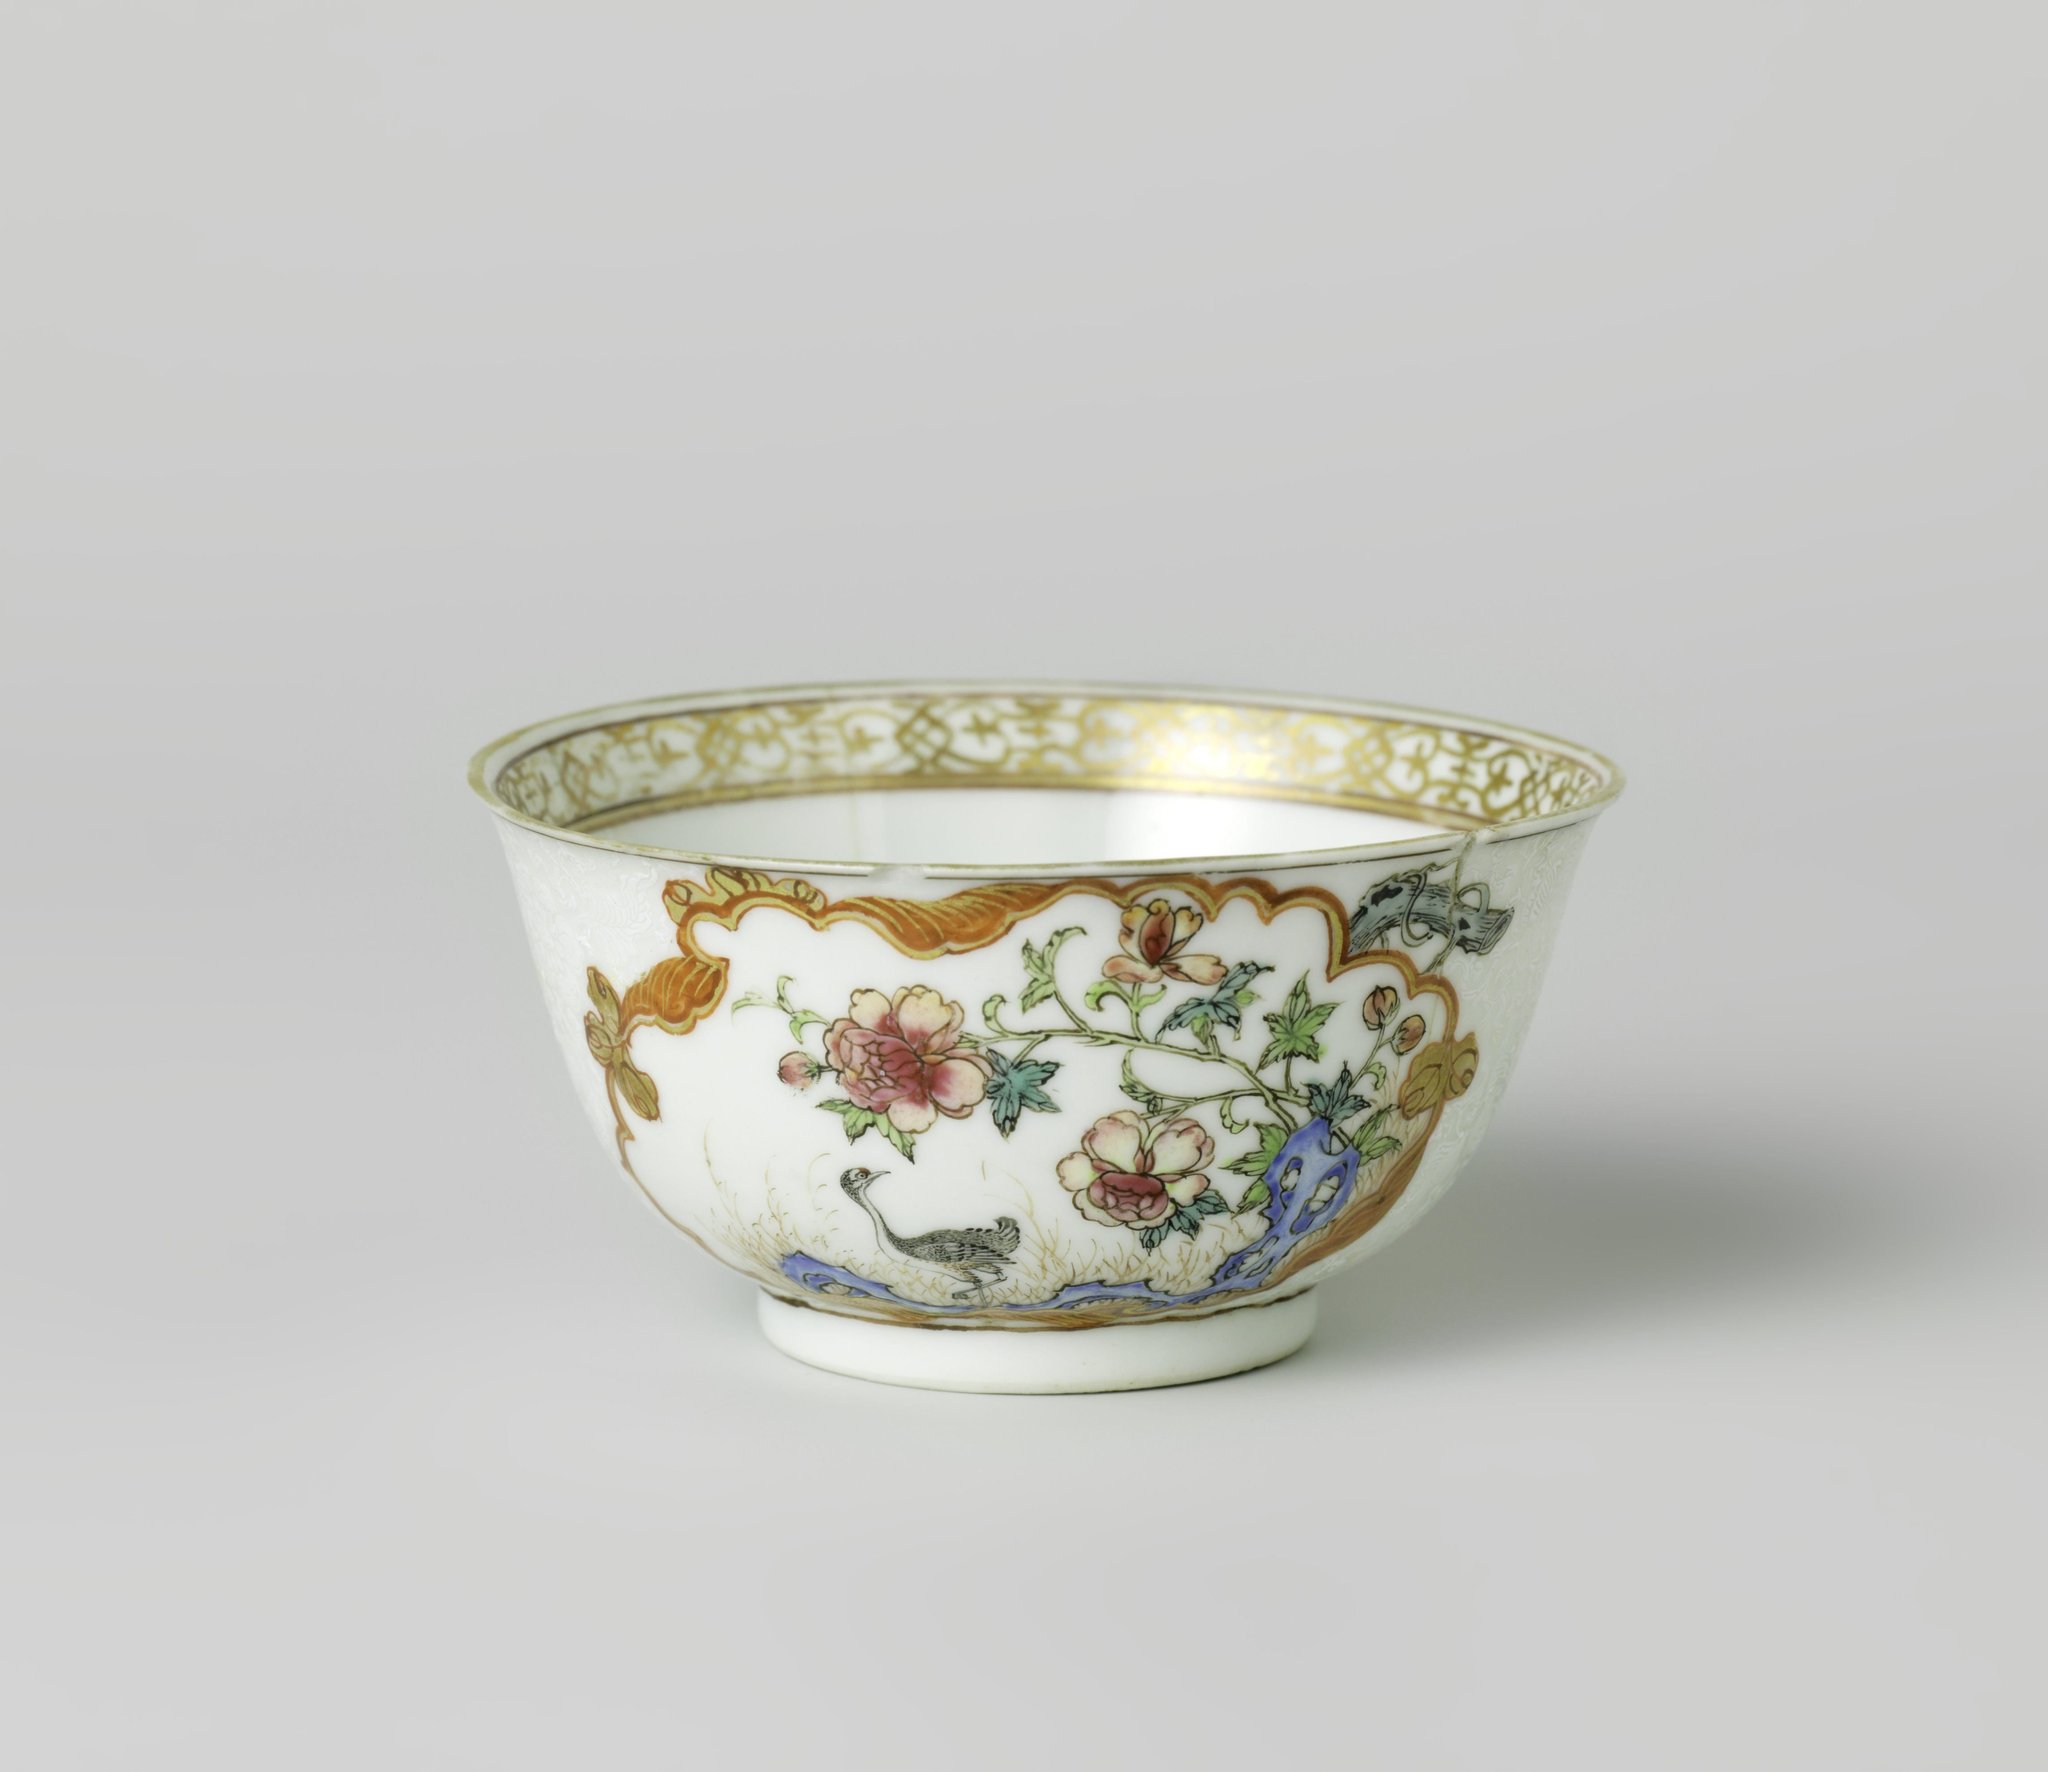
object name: cup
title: Bell-shaped cup with a crane near a peony plant and rock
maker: Anonymous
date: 1725-1749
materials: glaze, gold, paint, porcelain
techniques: firing, gilding, turning, vitrification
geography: china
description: Gedecoreerd in emails, goud en bianco sopra bianco met vogels en bloeiende planten.